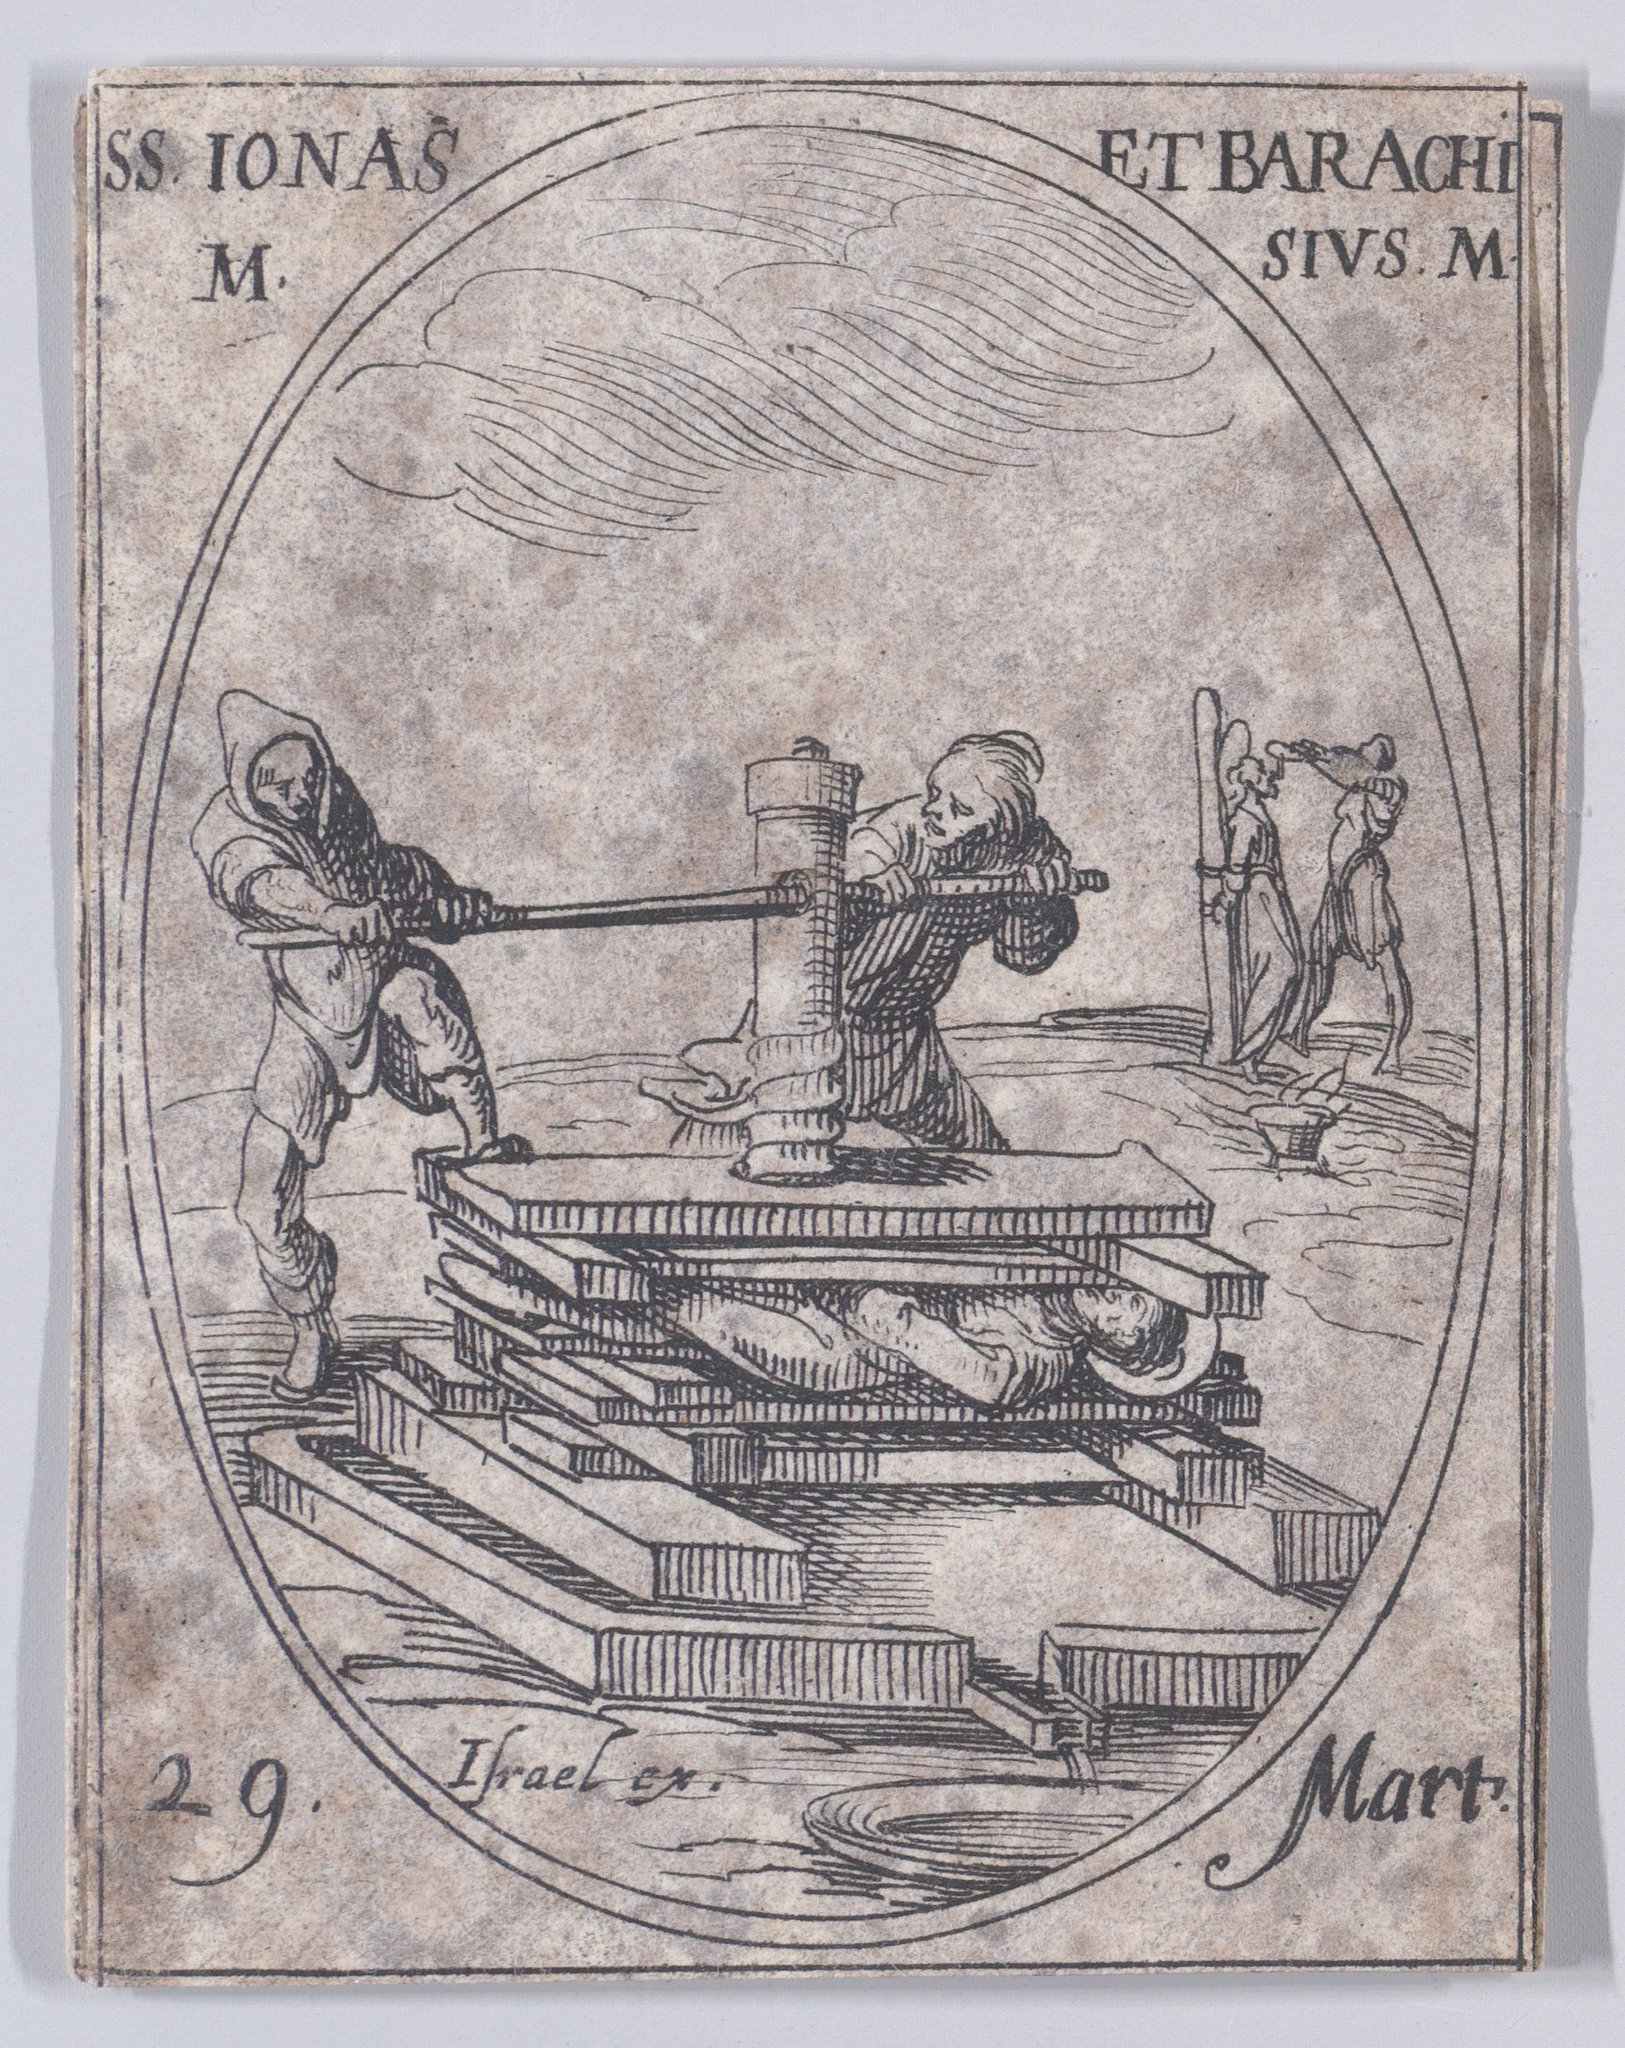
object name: print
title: S. Jonas et S. Barchise (St. Jonas and St. Barachisius), March 29th, from "Les Images De Tous Les Saincts et Saintes de L'Année" (Images of All of the Saints and Religious Events of the Year)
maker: jacques callot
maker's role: artist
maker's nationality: french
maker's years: 1592-1635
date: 1636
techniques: etching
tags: men,saints